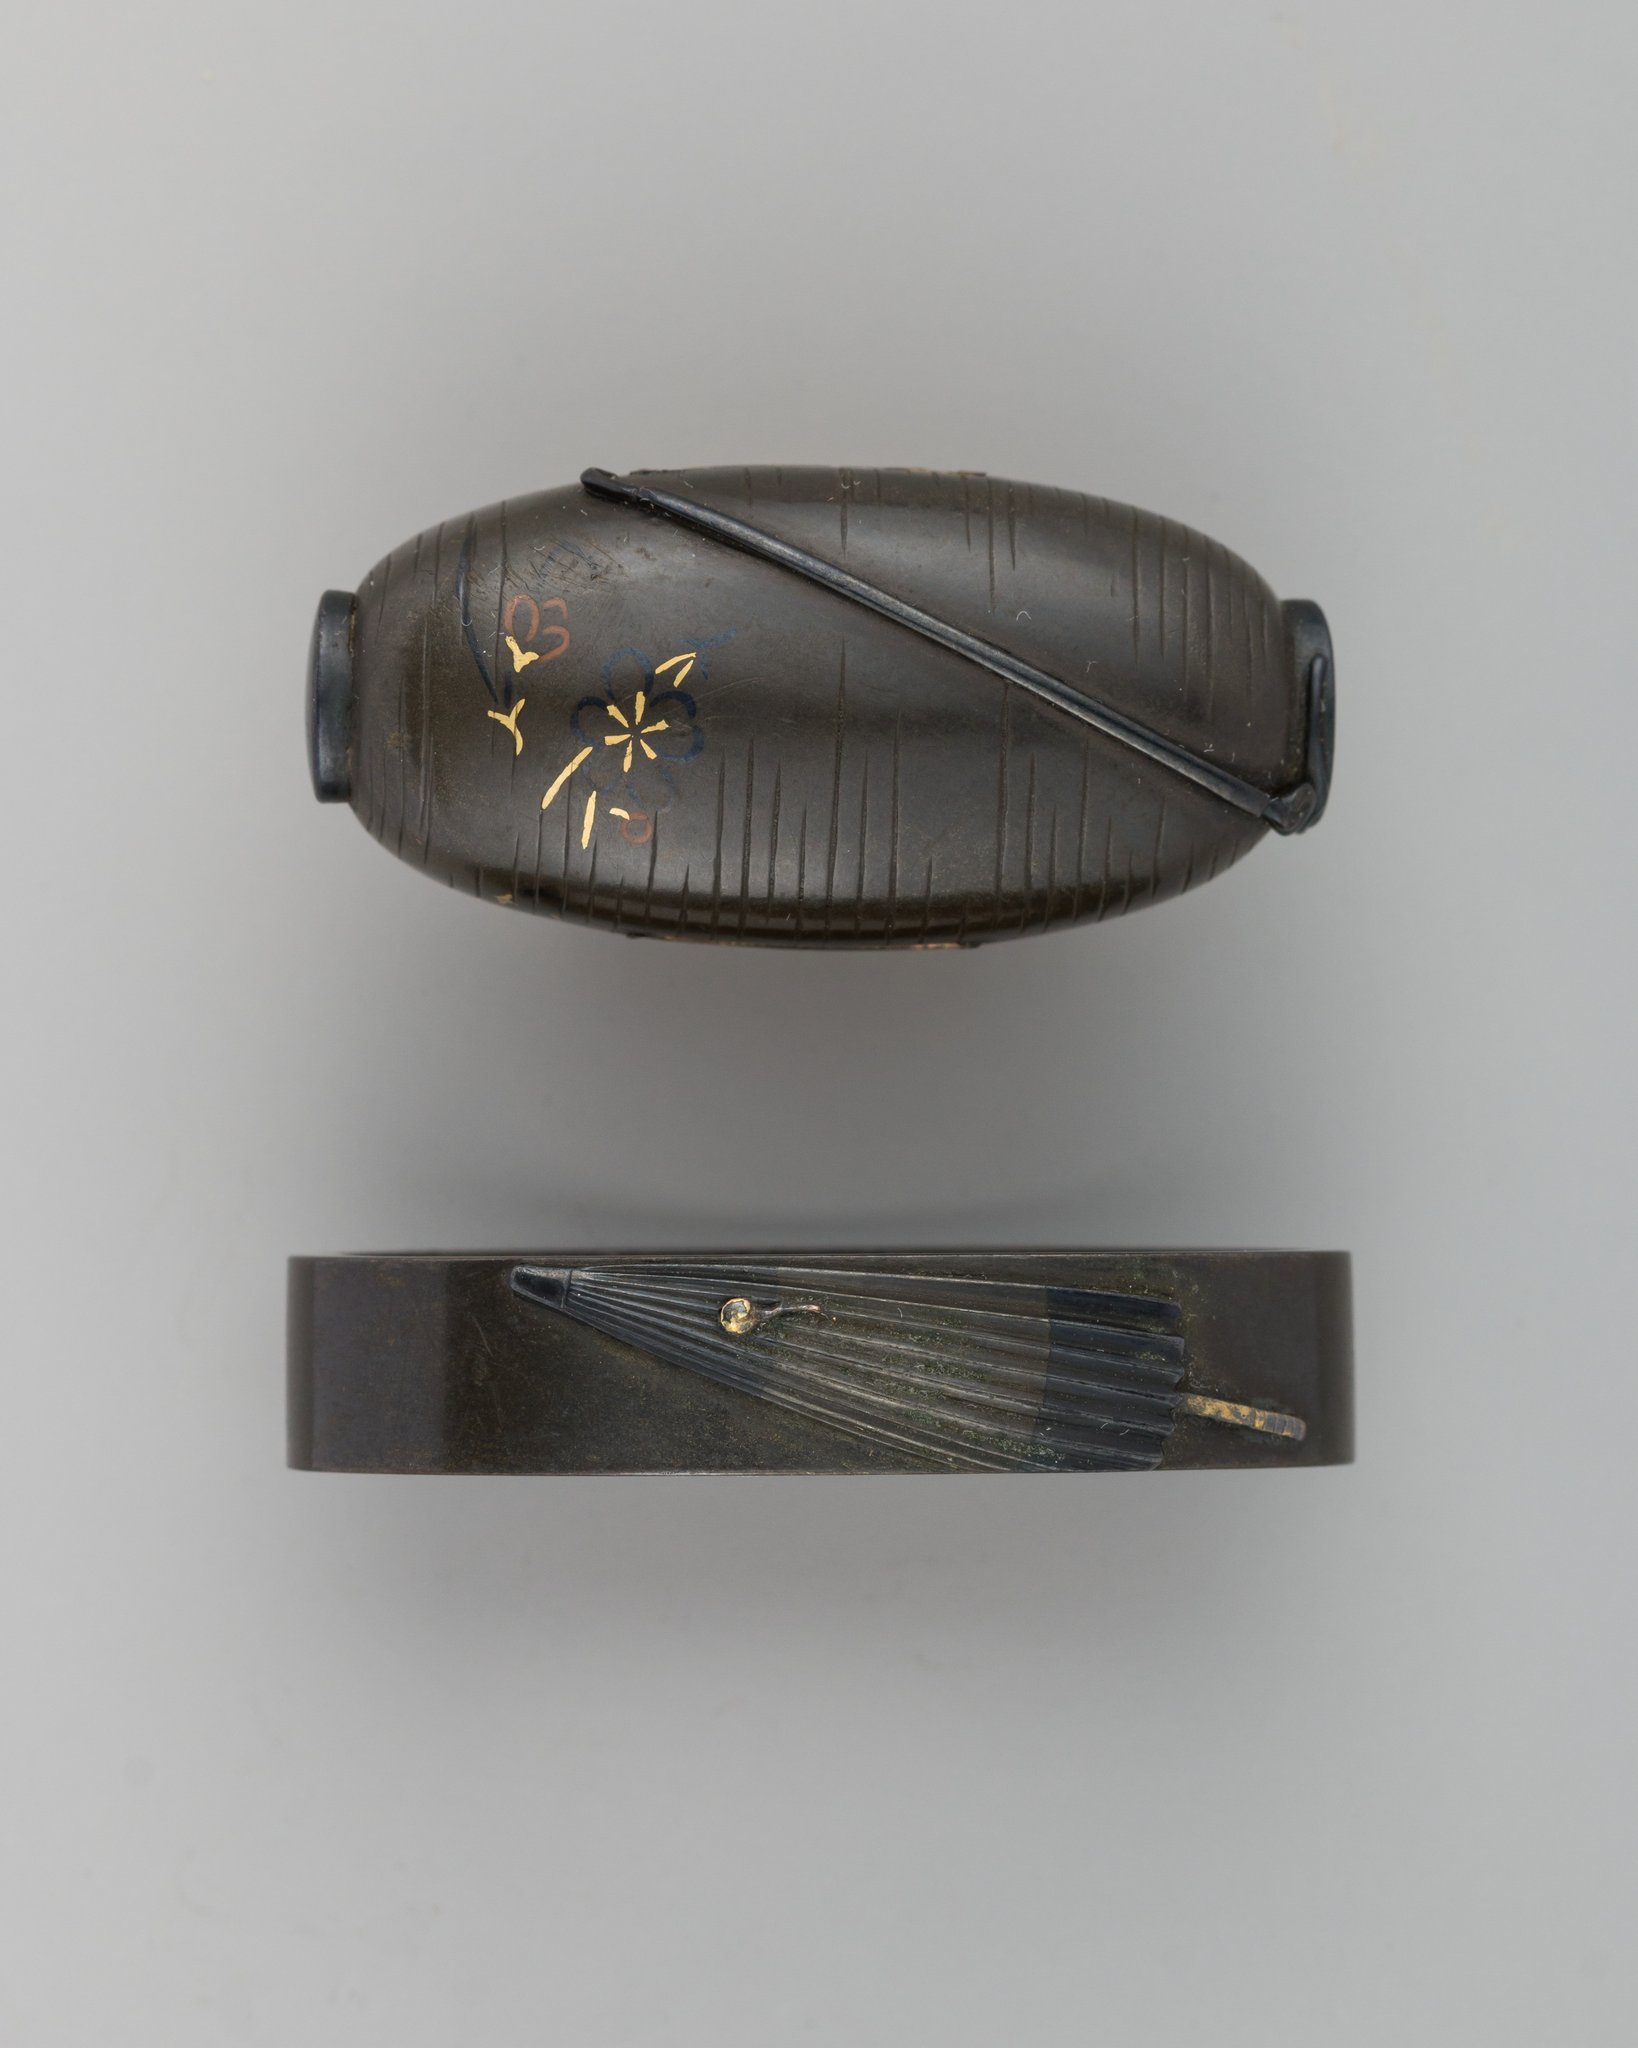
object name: sword hilt collar and pommel fuchigashira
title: Sword-Hilt Collar and Pommel (Fuchigashira)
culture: japanese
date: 1615-1868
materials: copper, gold alloy, silver alloy, gold, silver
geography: japan